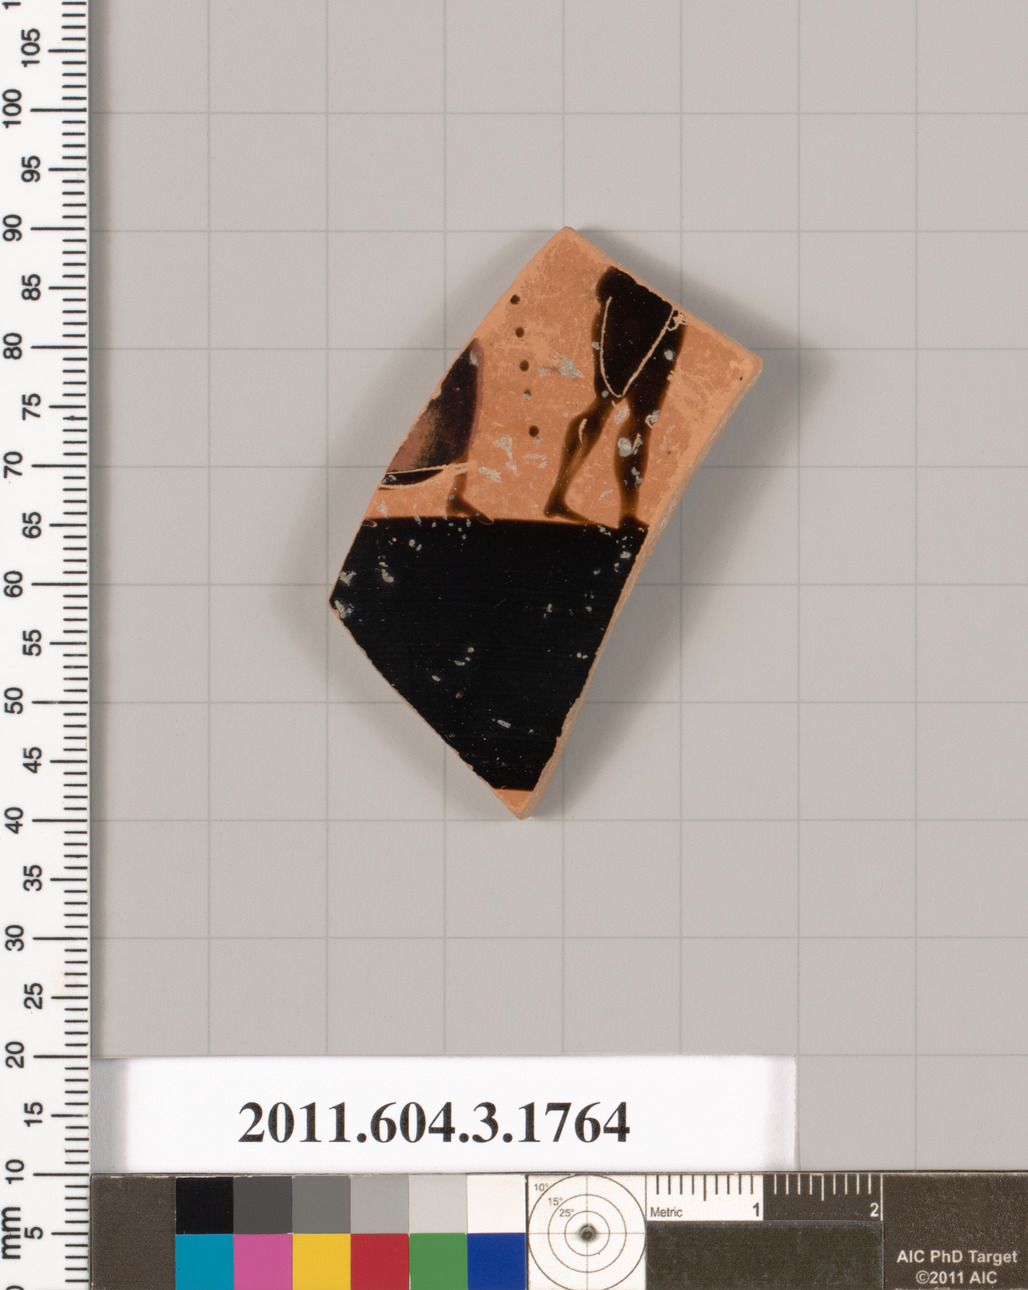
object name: kylix fragment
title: Terracotta fragment of a kylix: Band cup (drinking cup)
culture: greek, attic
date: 550-501 BCE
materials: terracotta